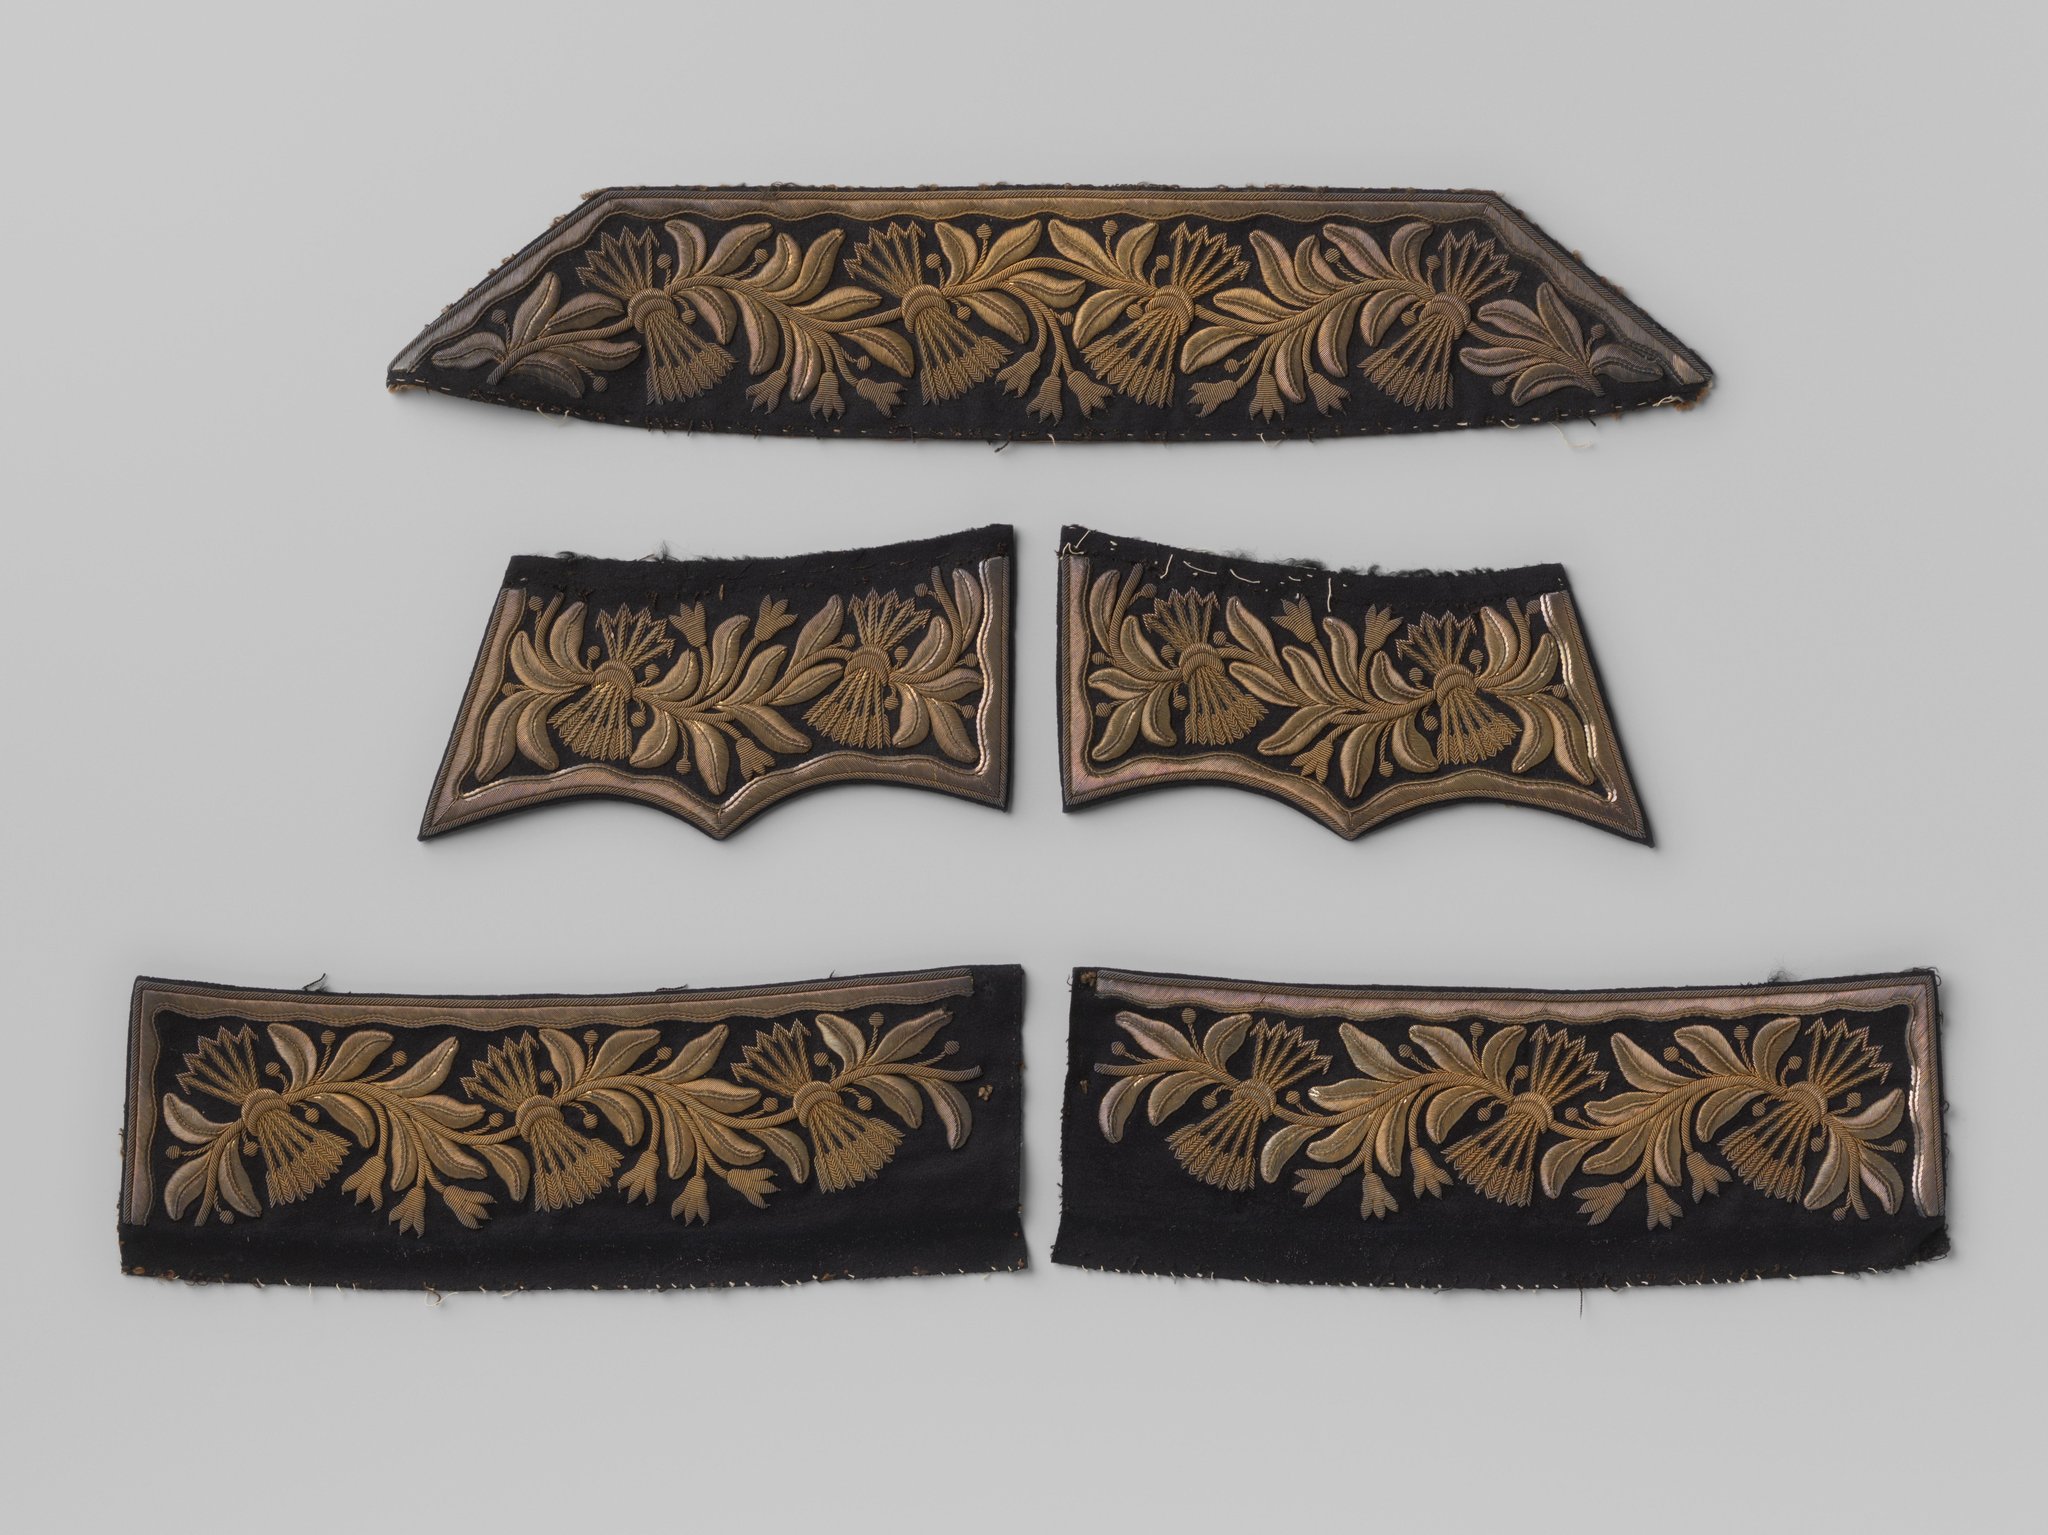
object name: embroidery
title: Borduursel voor jas van J.R. Thorbecke (manchet)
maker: Anonymous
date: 1850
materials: textile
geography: netherlands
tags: the hague, johan rudolf thorbecke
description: Borduursel voor jas behorende bij ambtskostuum van J.R. Thorbecke als minister van Binnenlandse Zaken.